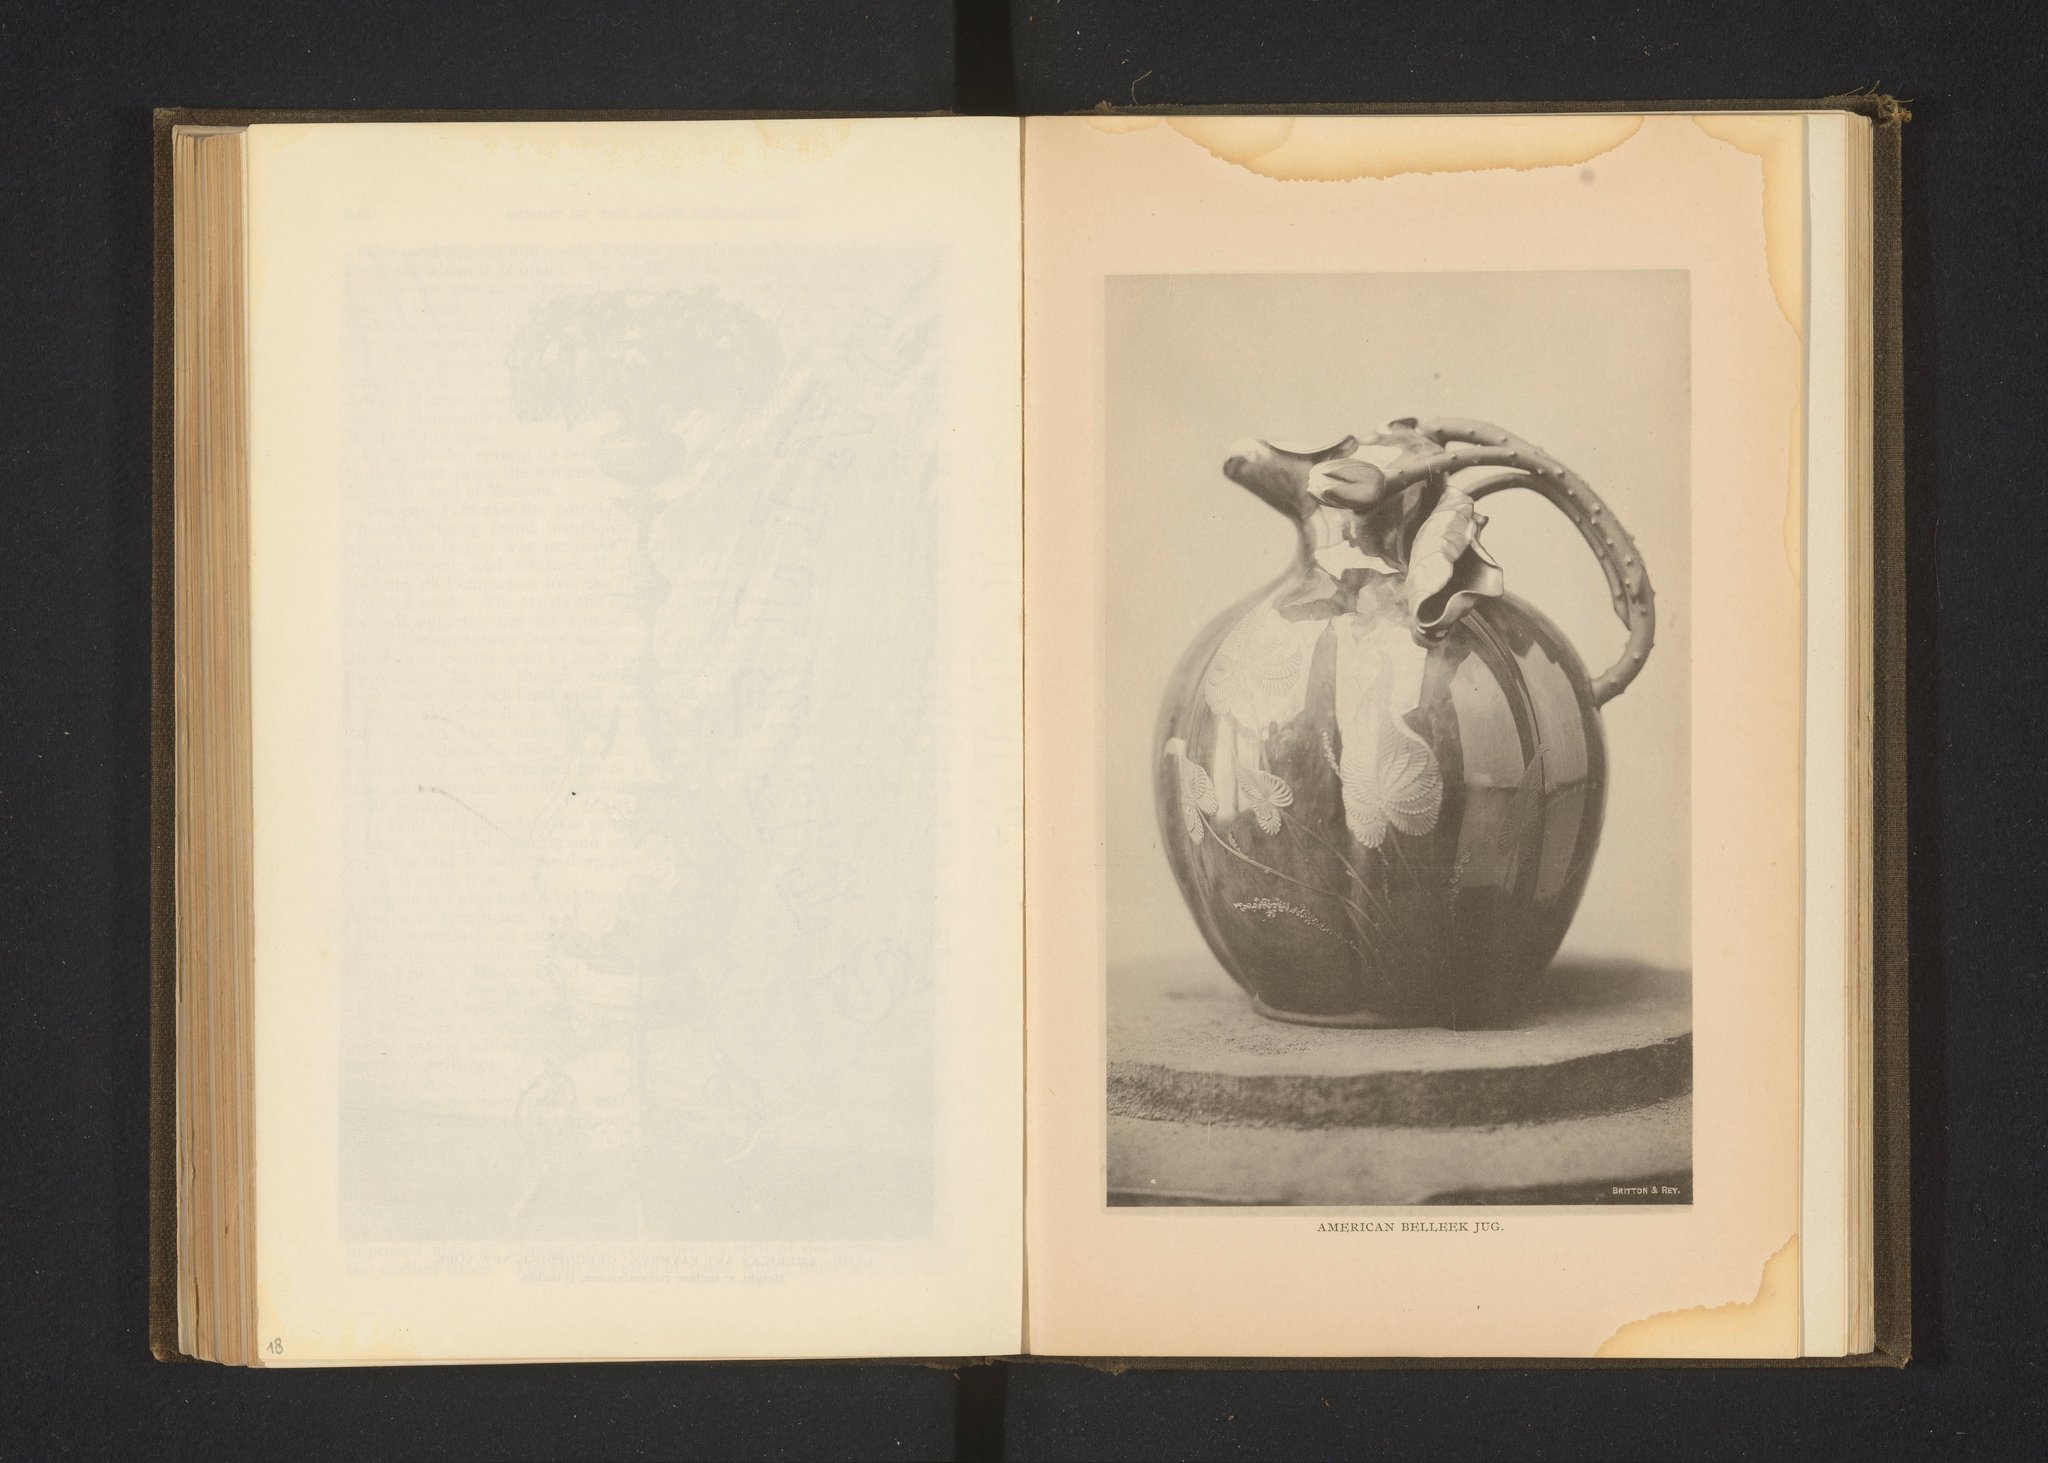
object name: photomechanical print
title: American Belleek Jug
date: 1885-1890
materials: paper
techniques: photograph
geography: north and central america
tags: vase ~ ornament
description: Prent op tweede ongenummerde pagina na pagina 246.